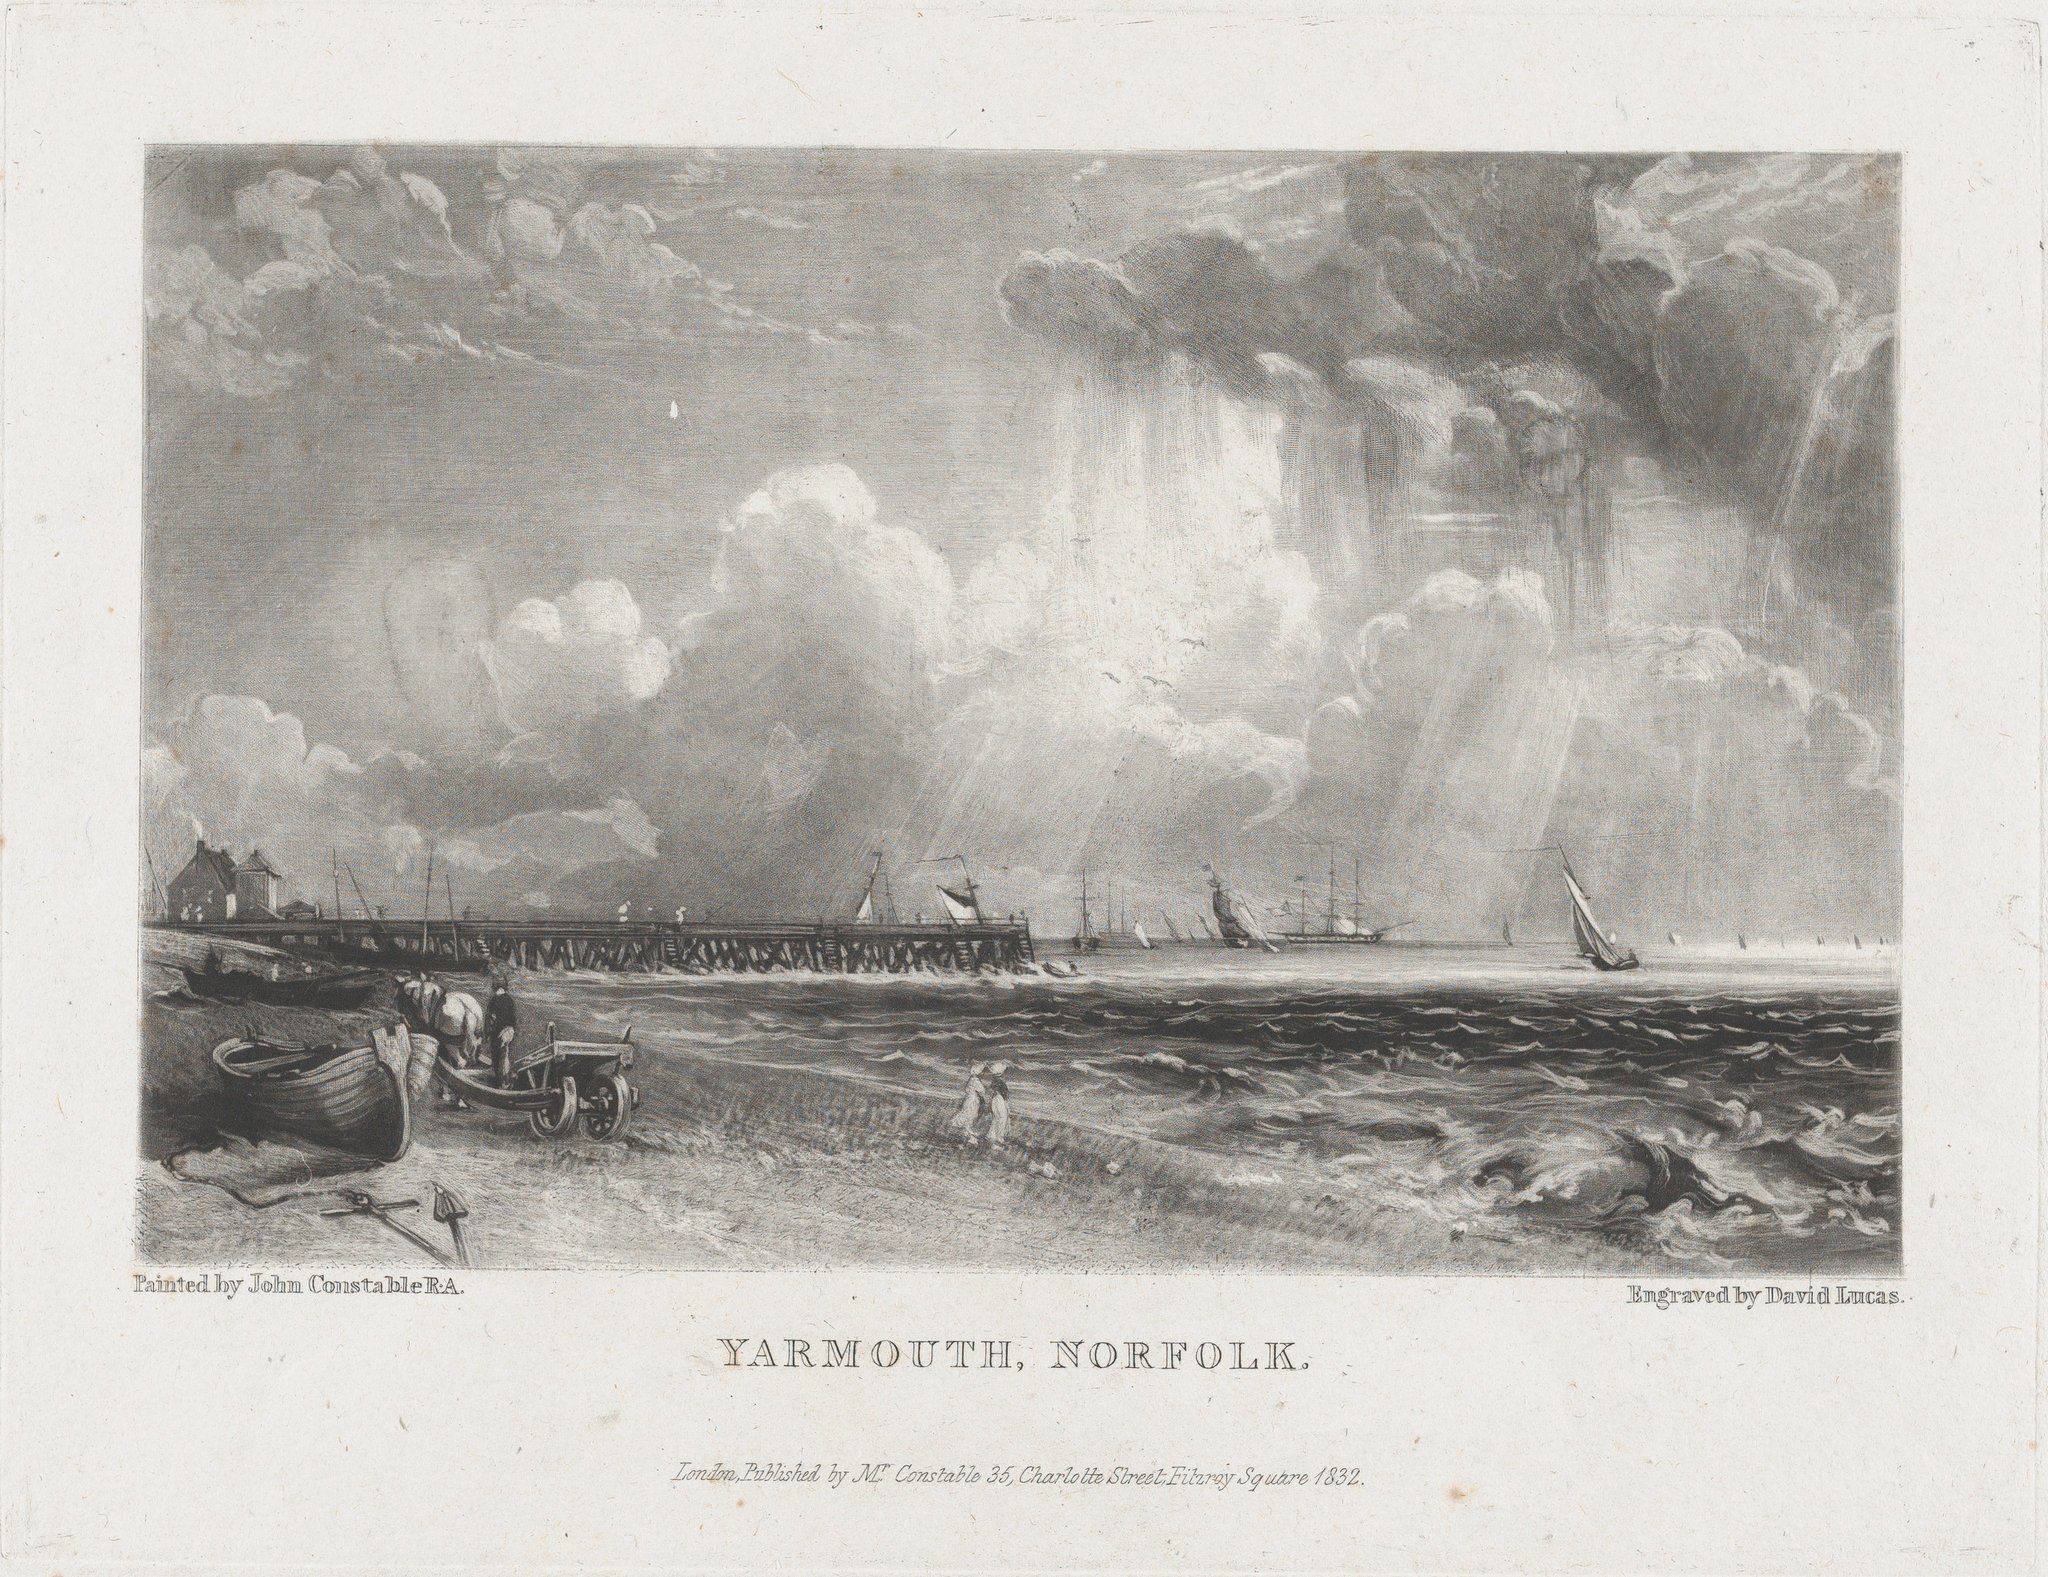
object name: print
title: Yarmouth, Norfolk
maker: david lucas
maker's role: artist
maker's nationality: british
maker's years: 1802-1881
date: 1832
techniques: mezzotint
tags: seascapes,boats,piers